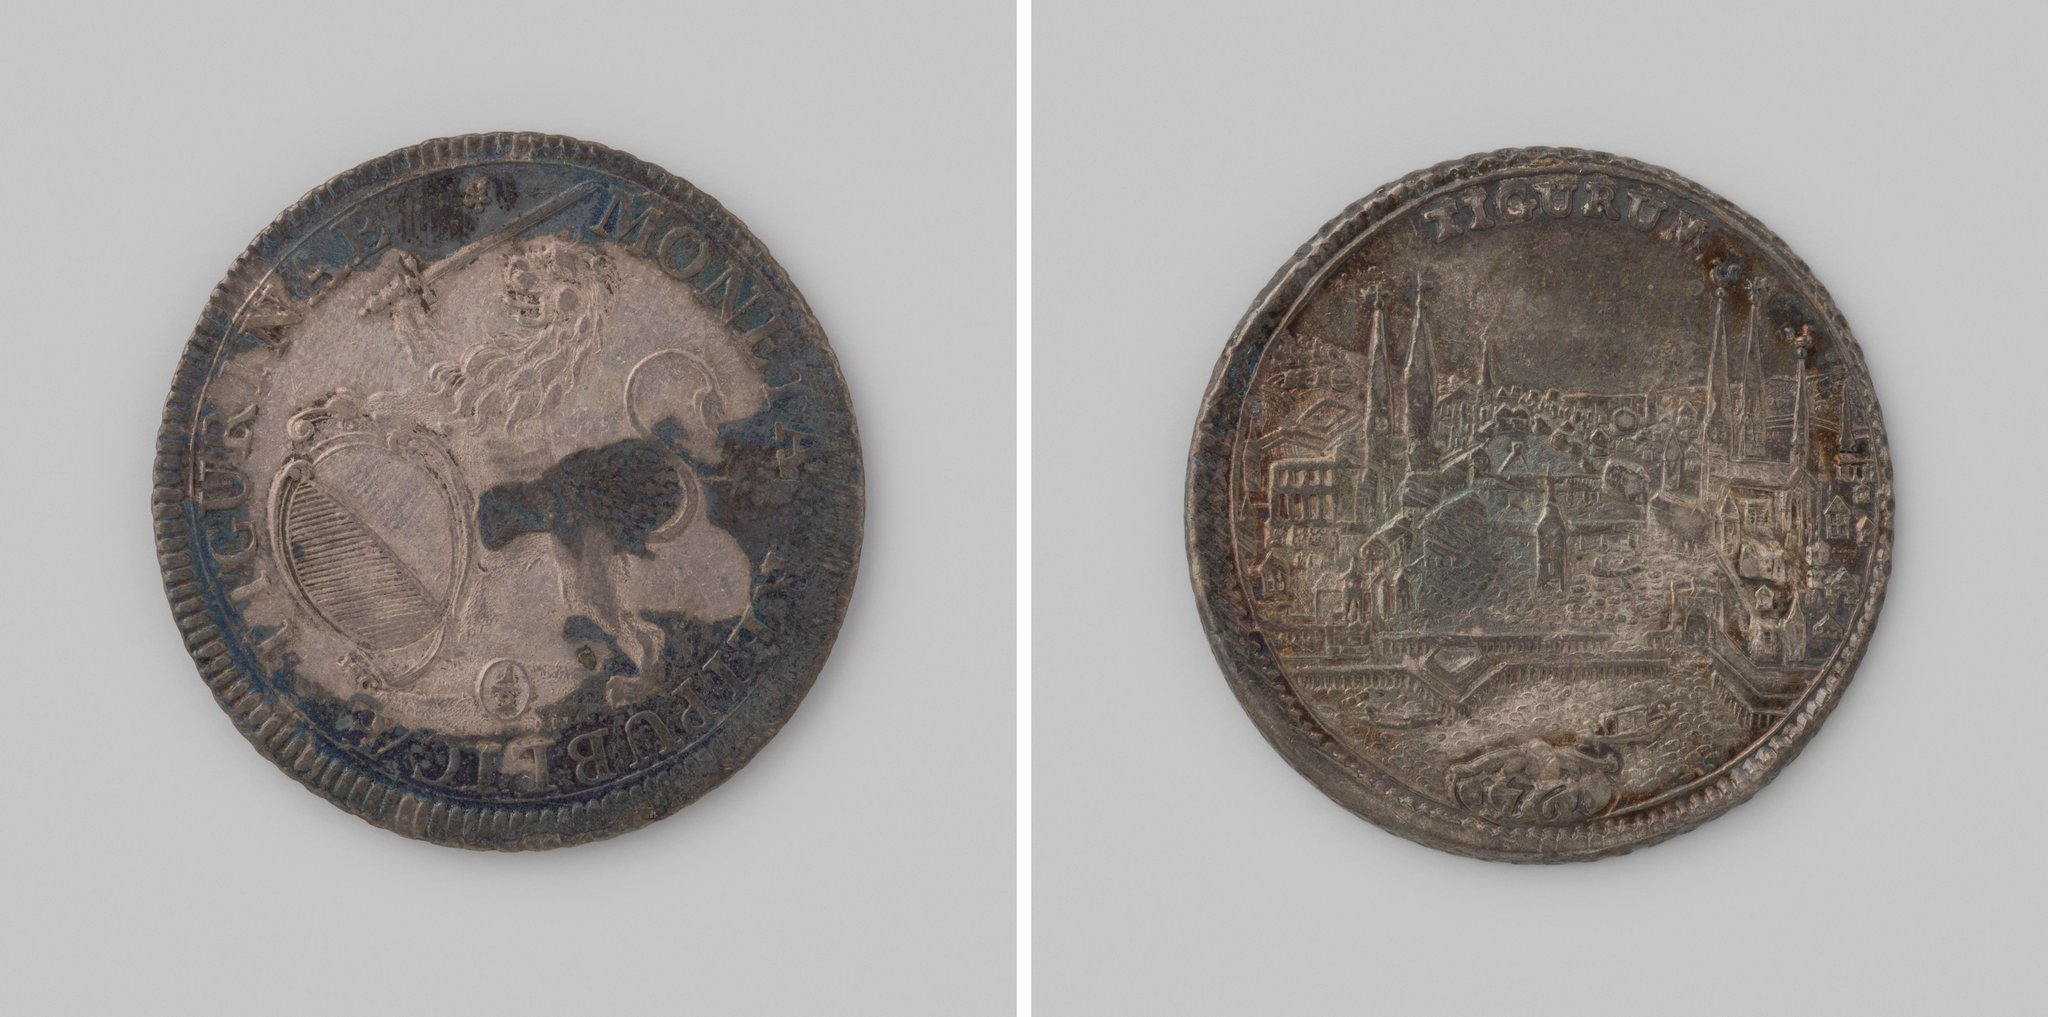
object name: gulden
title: Kanton Zürich, ½ Taler of gulden,1761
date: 1761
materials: silver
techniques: striking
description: Zilveren munt. Voorzijde: staande leeuw naar links met in zijn rechterklauw zwaard en met zijn linkerversierd wapenschild vasthoudend. Darrtussen waarde-aanduiding: ½.. Keerzijde:stadsgezicht. Jaartal onderaan in versiering. Kabelrand.